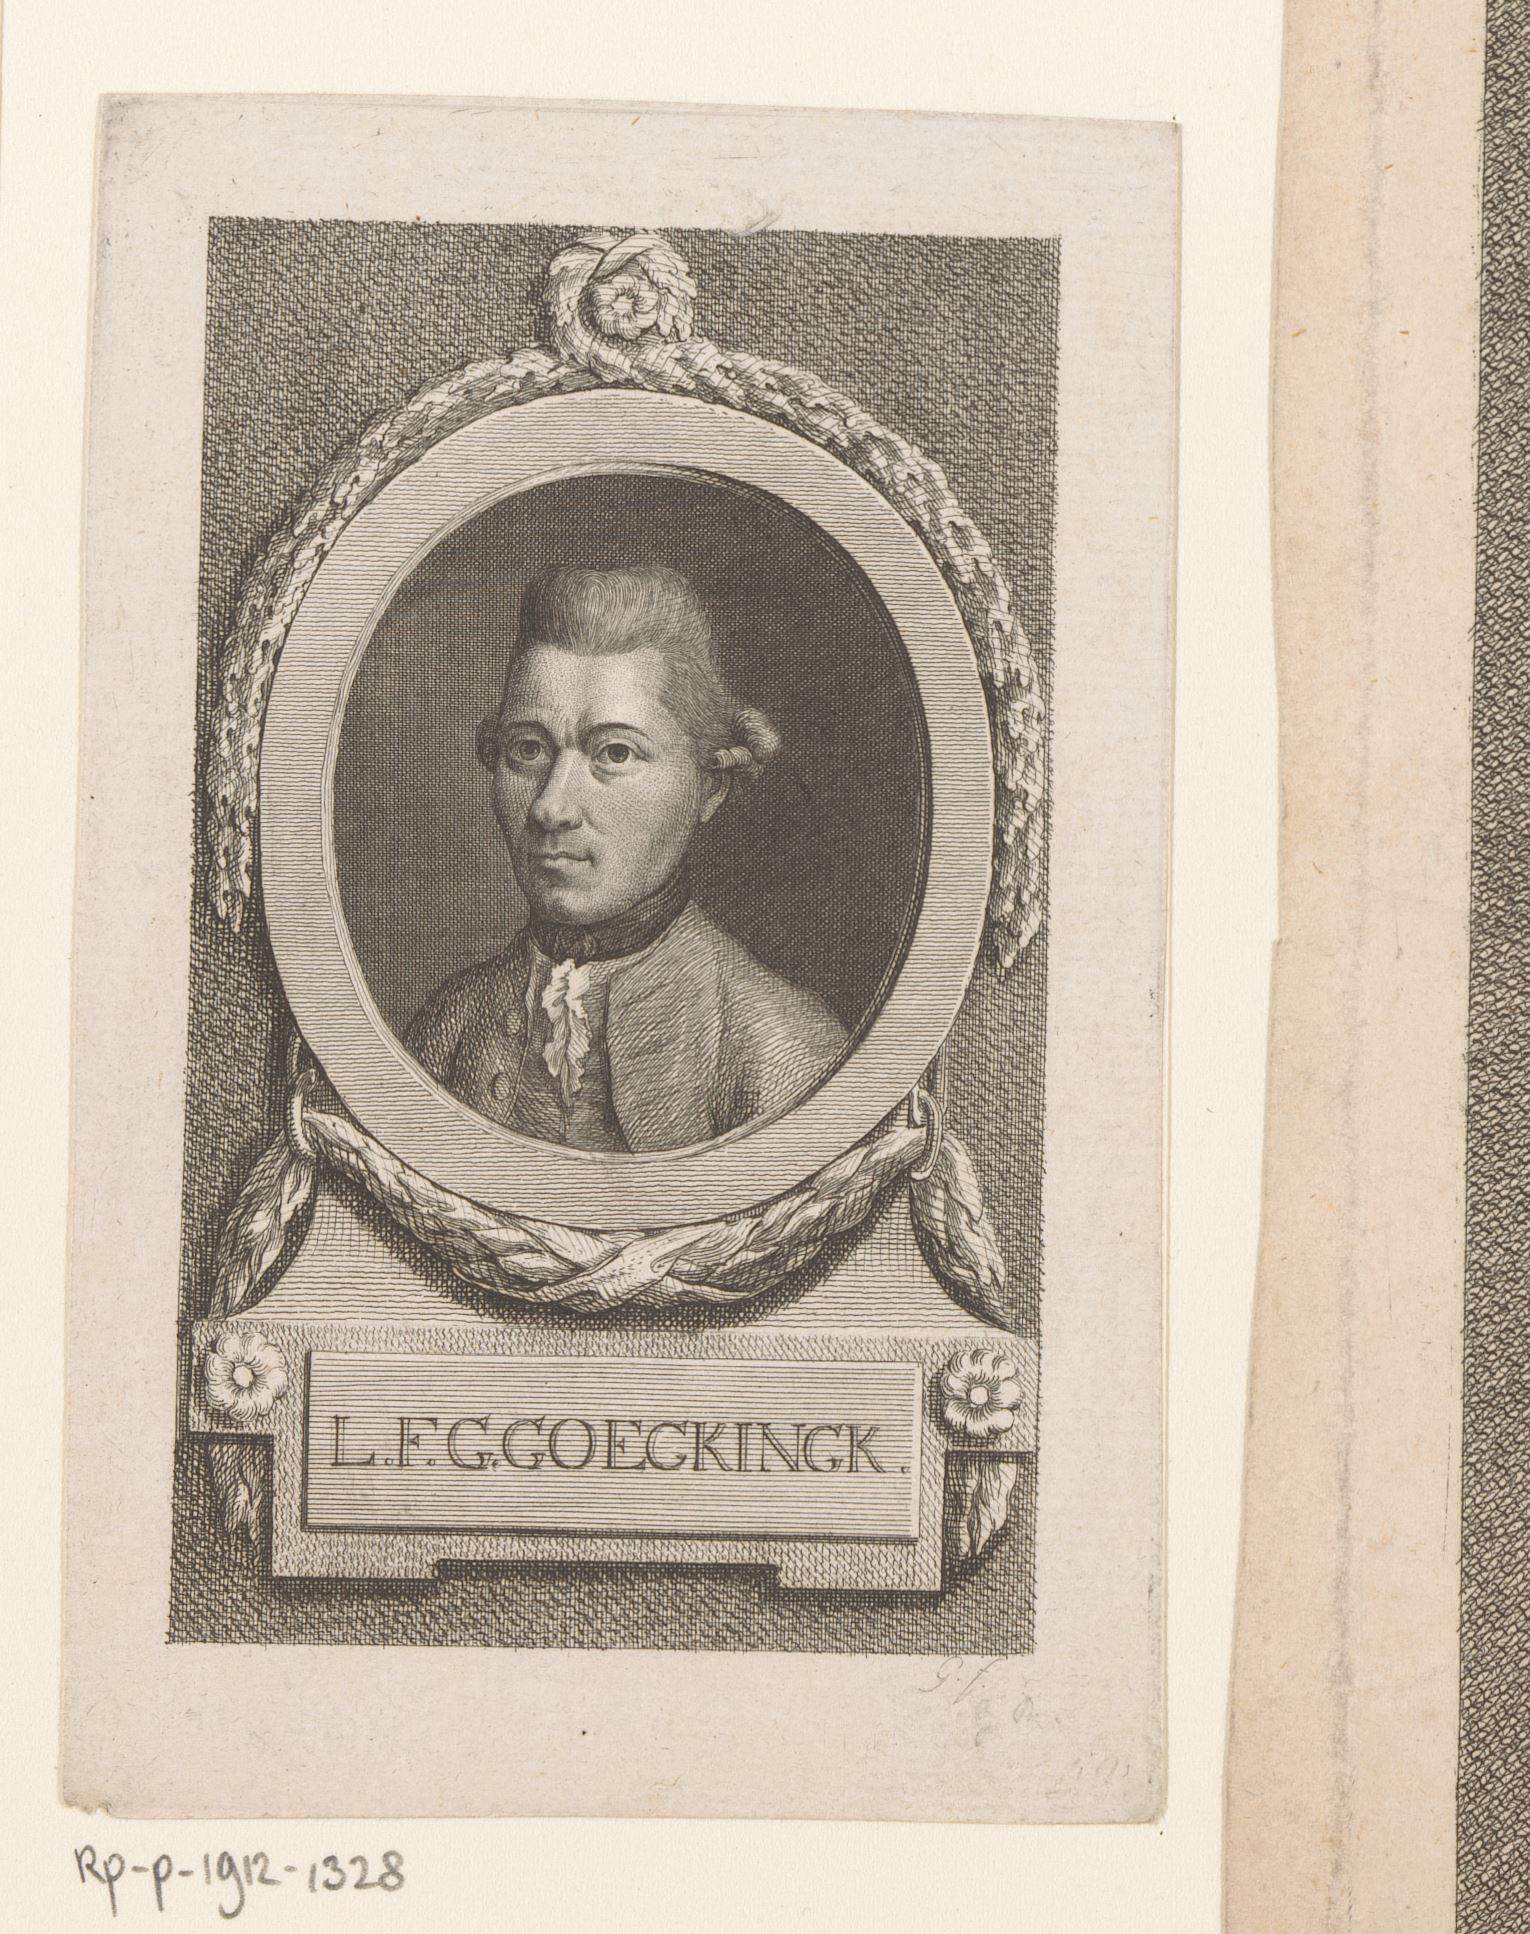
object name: print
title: Portret van Leopold Friedrich Günther von Goeckingk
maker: christian gottlieb geyser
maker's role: print maker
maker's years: 1742-1803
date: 1758-1803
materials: paper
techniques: engraving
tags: historical persons, writer, poet, author, ornament ~ festoon, garland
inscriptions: collector's mark: Lugt 2228